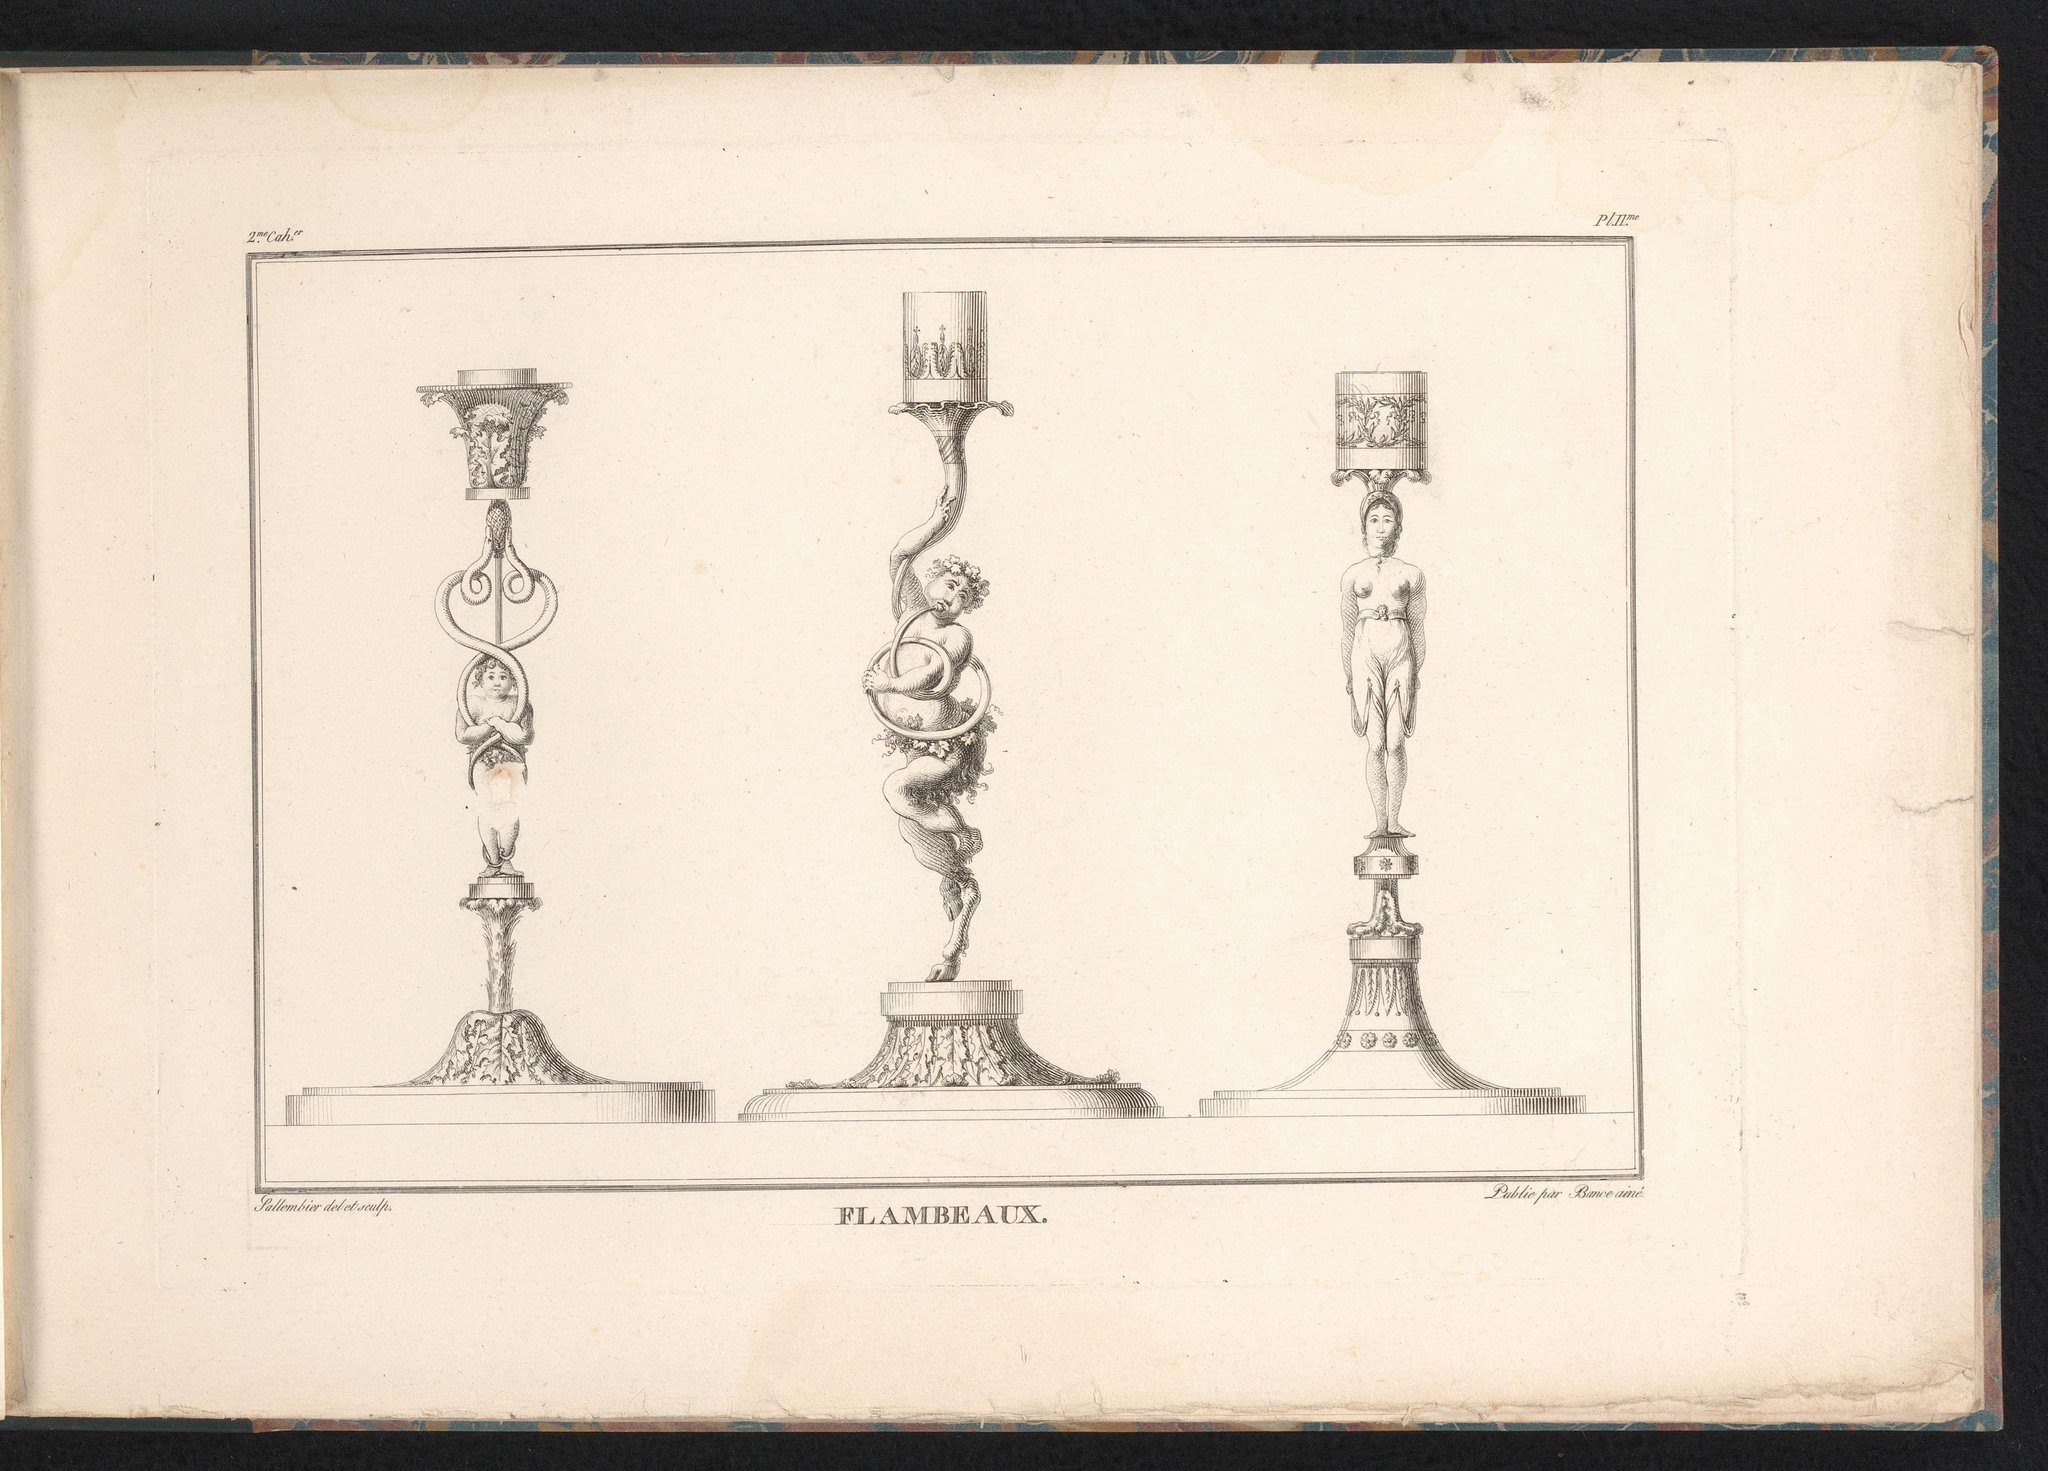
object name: print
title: Drie kandelaars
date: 1805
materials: paper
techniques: etching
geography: paris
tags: caryatids ~ architecture, chandelier, candelabrum, satyr(s) (in general)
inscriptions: number: ‘2.me Cah.er’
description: Ontwerpen voor drie kandelaars met een sater en kariatiden. Prent maakt deel uit van een album.